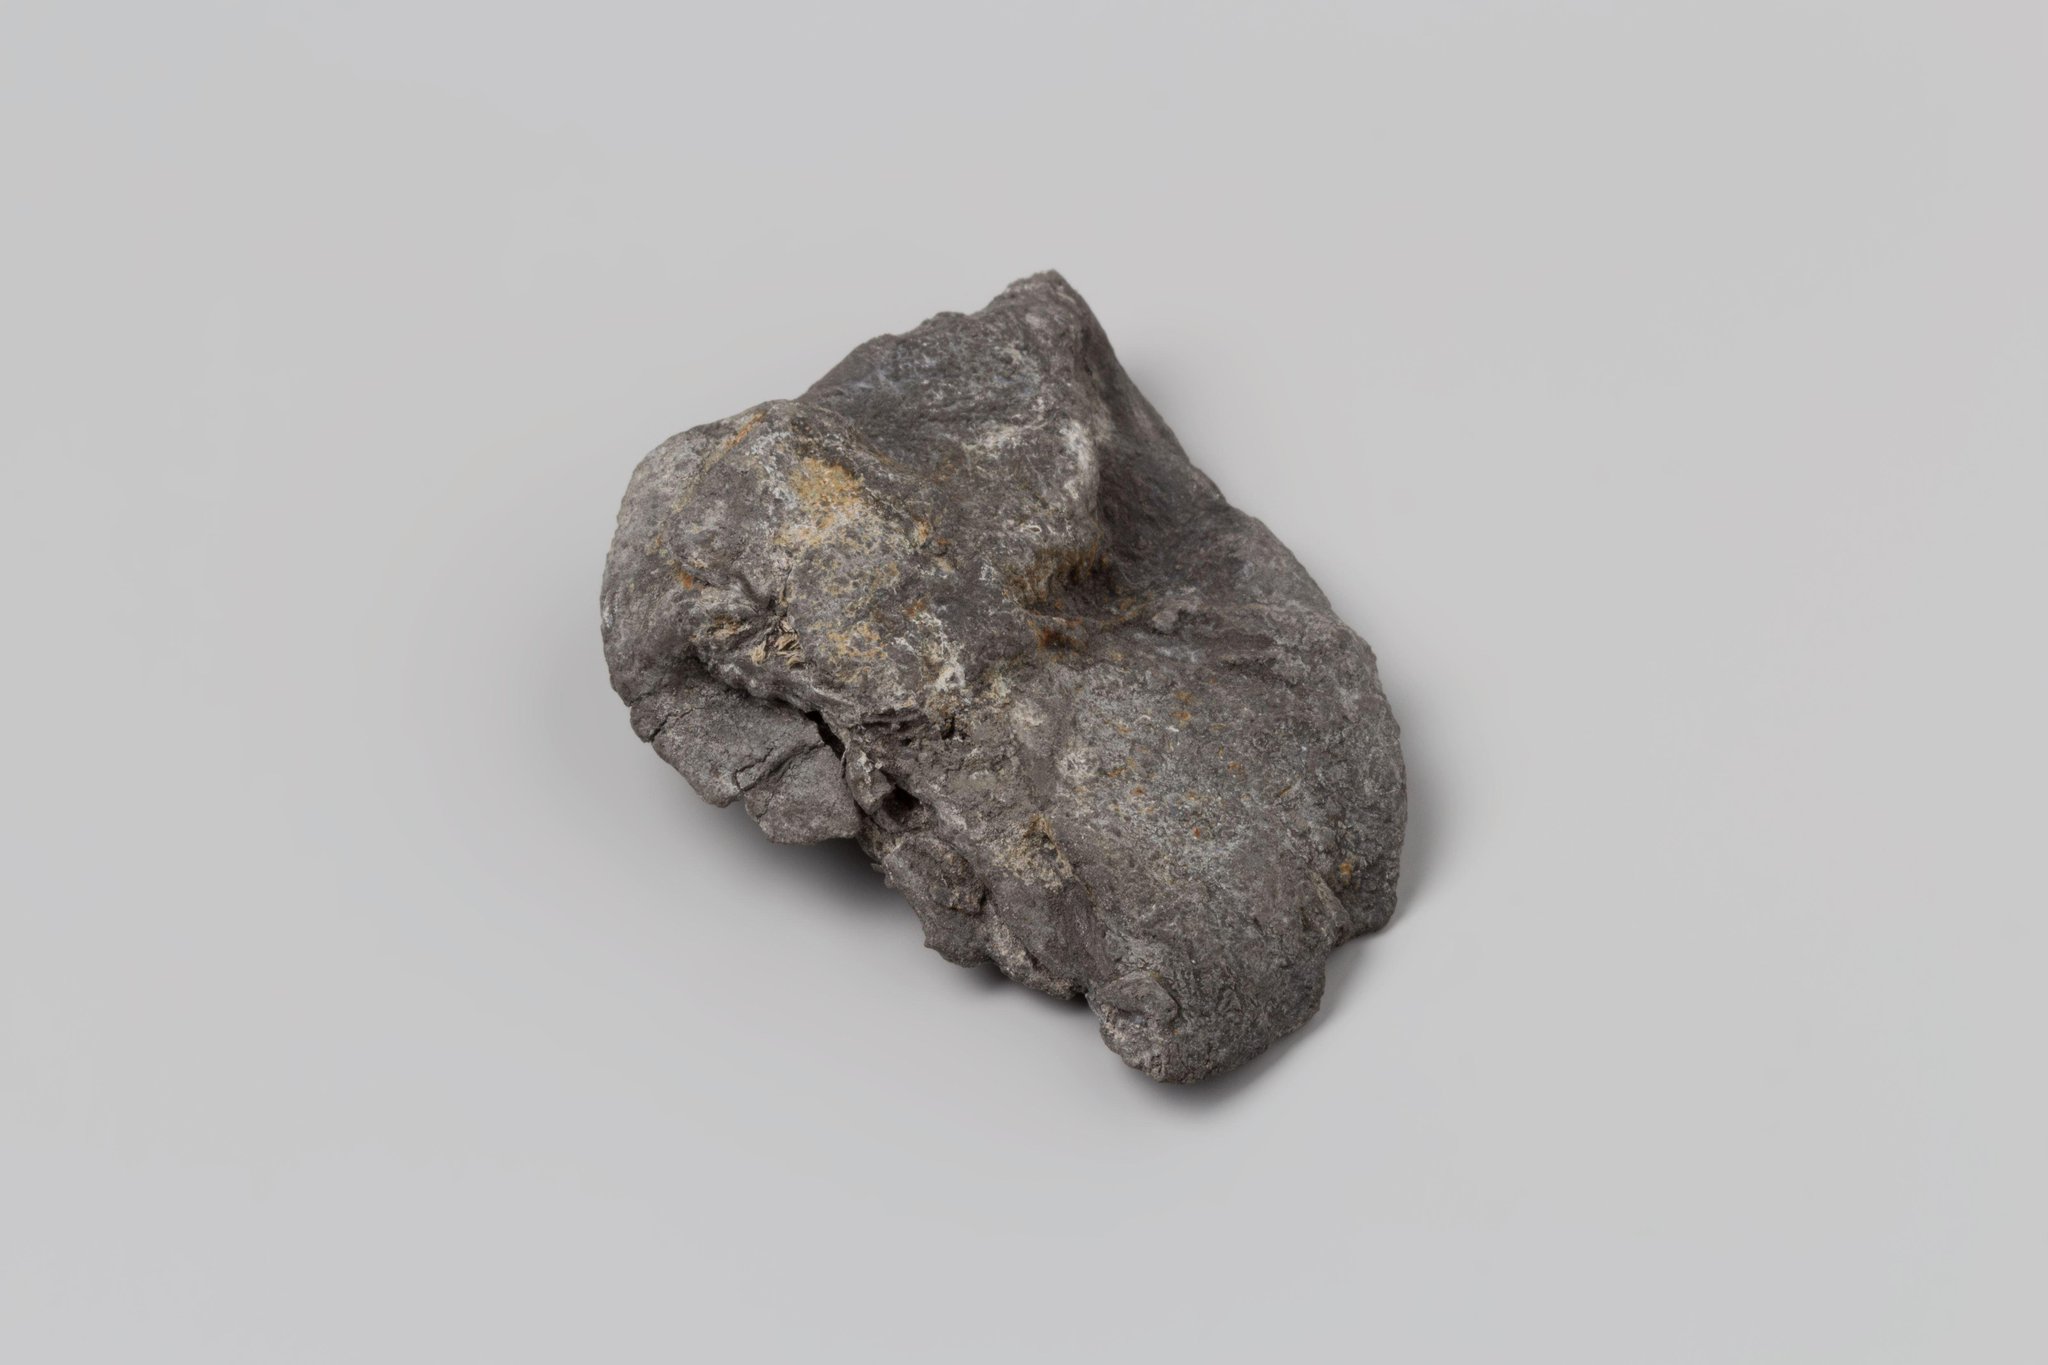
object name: ewer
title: Fragment kan uit het wrak van de Oost-Indiëvaarder 't Vliegend Hart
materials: tin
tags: 't vliegend hart (schip), verenigde oostindische compagnie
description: Deel van een tinnen kan, geplet en gecorrodeerd. Grijs tot zwart van kleur. Jug.